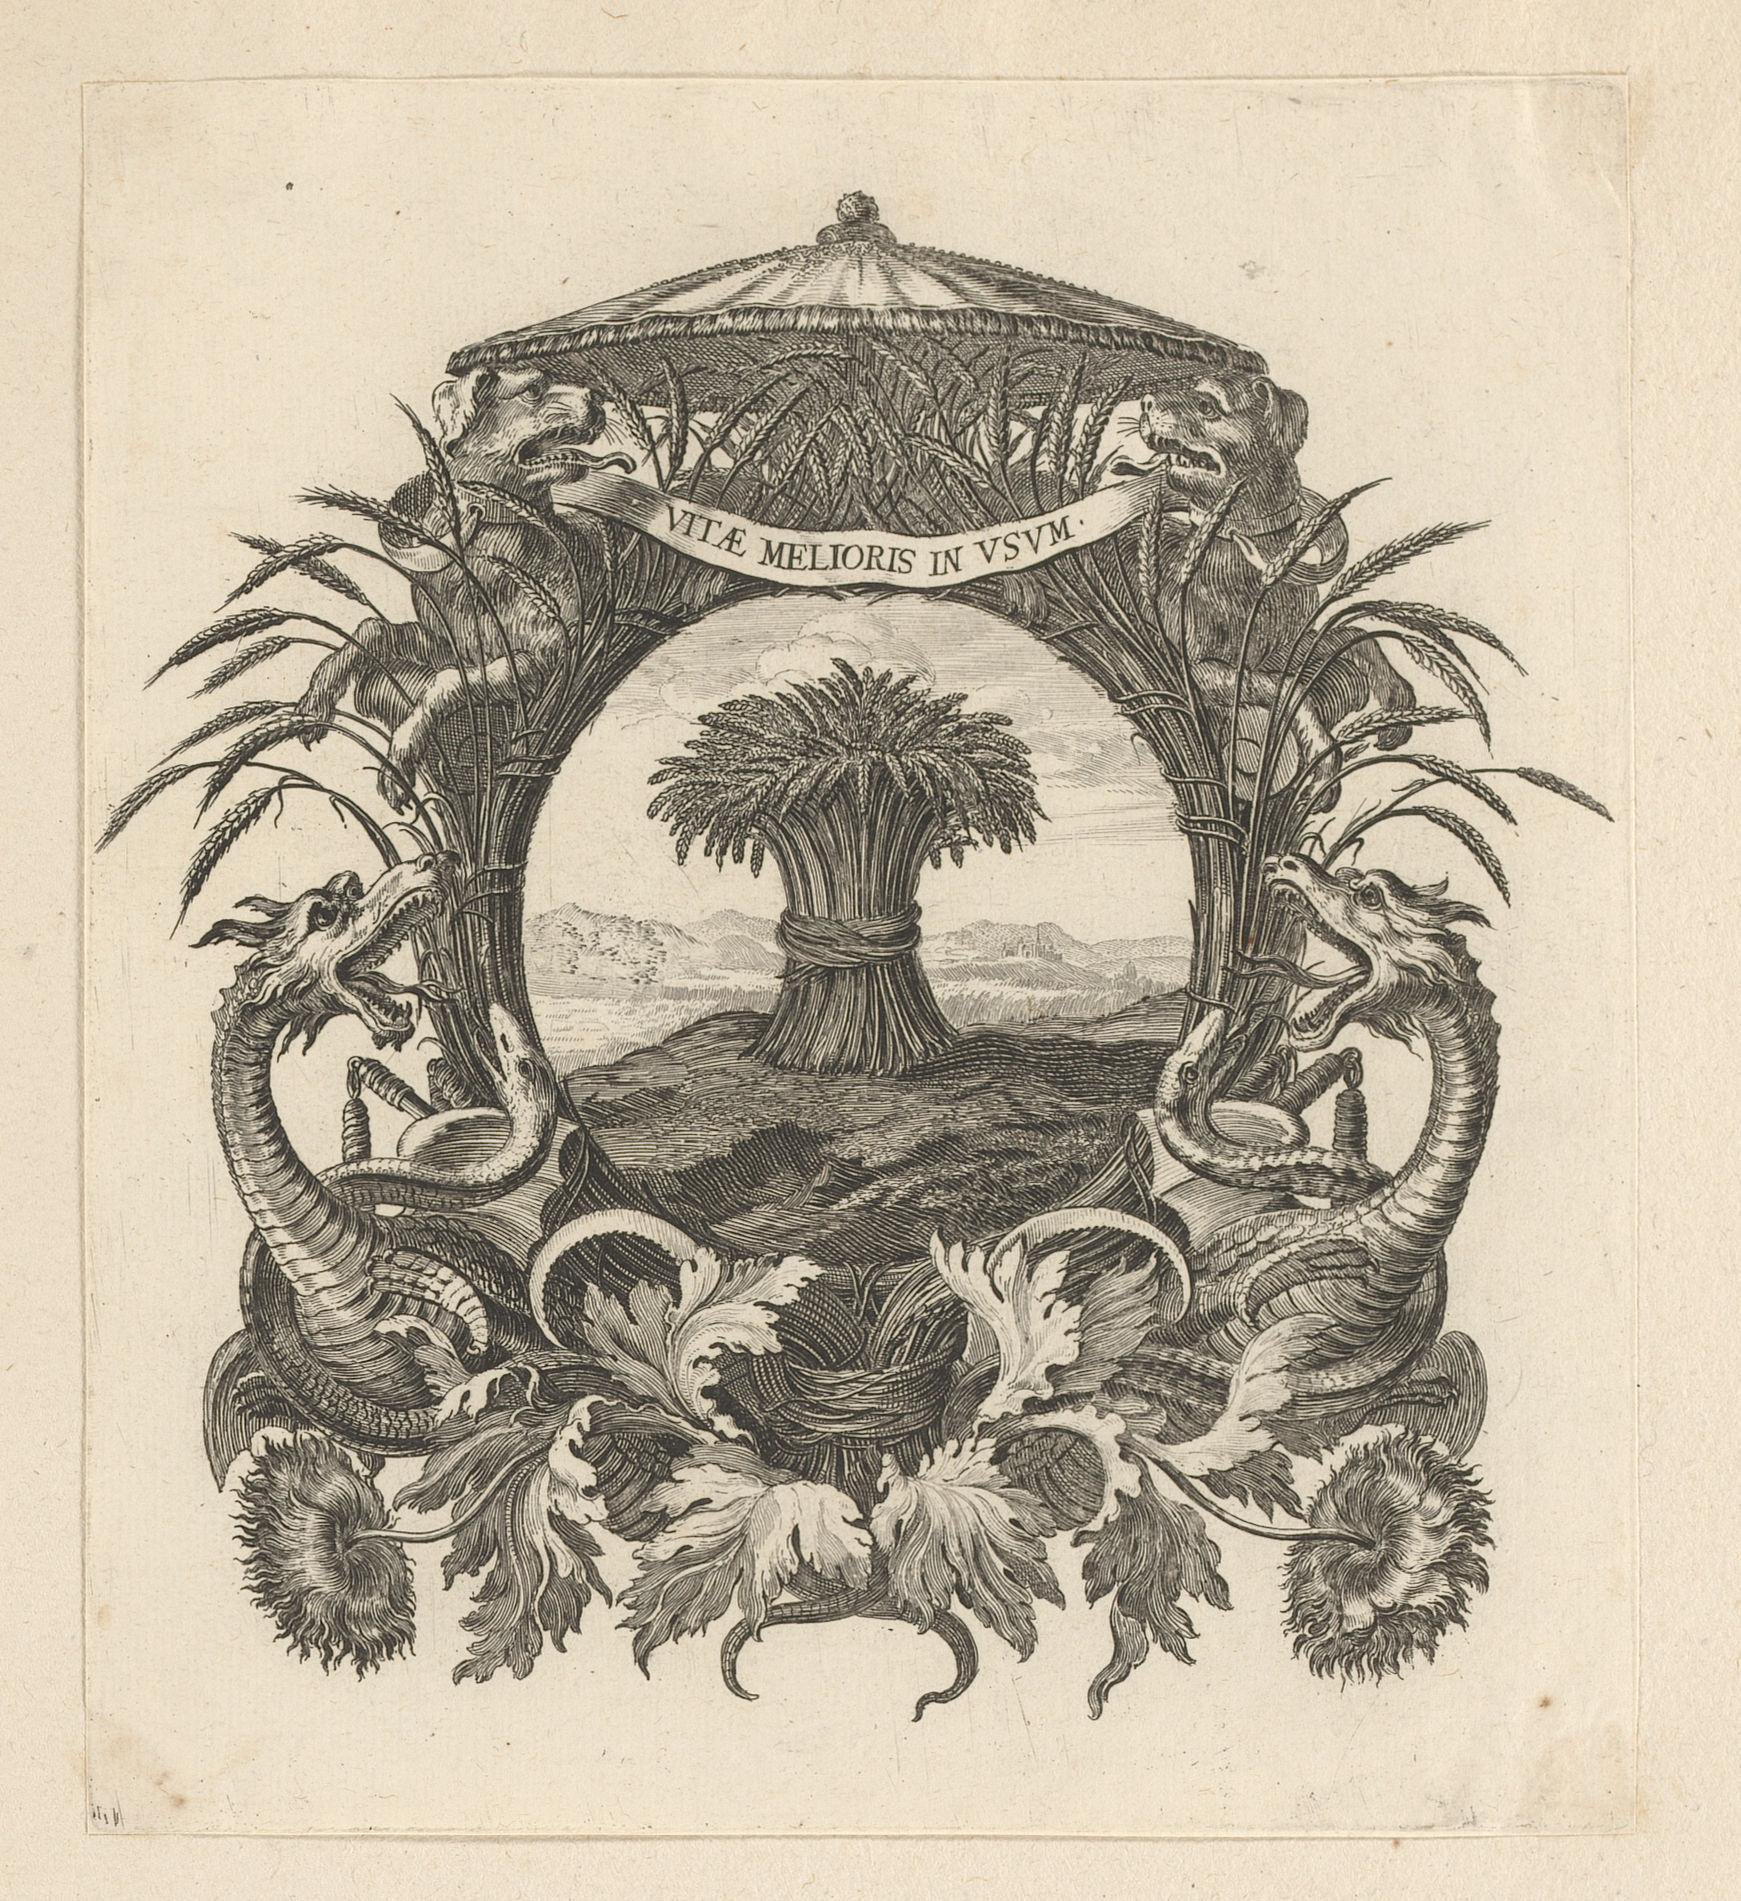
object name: print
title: Vitae melioris in usum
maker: sébastien leclerc (i)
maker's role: print maker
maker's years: 1637-1714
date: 1670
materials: paper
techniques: etching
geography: paris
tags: plants and herbs: wheat, snakes, summer, 'aestas'; 'estate' (ripa), sheaf, dragon, dog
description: Prent gebruikt voor: Félibien, André. Devises pour les tapisseries du Roy, où sont représentez les quatre éléments et les quatre saisons de l'année (...). Parijs: Imprimerie Royale, 1670.